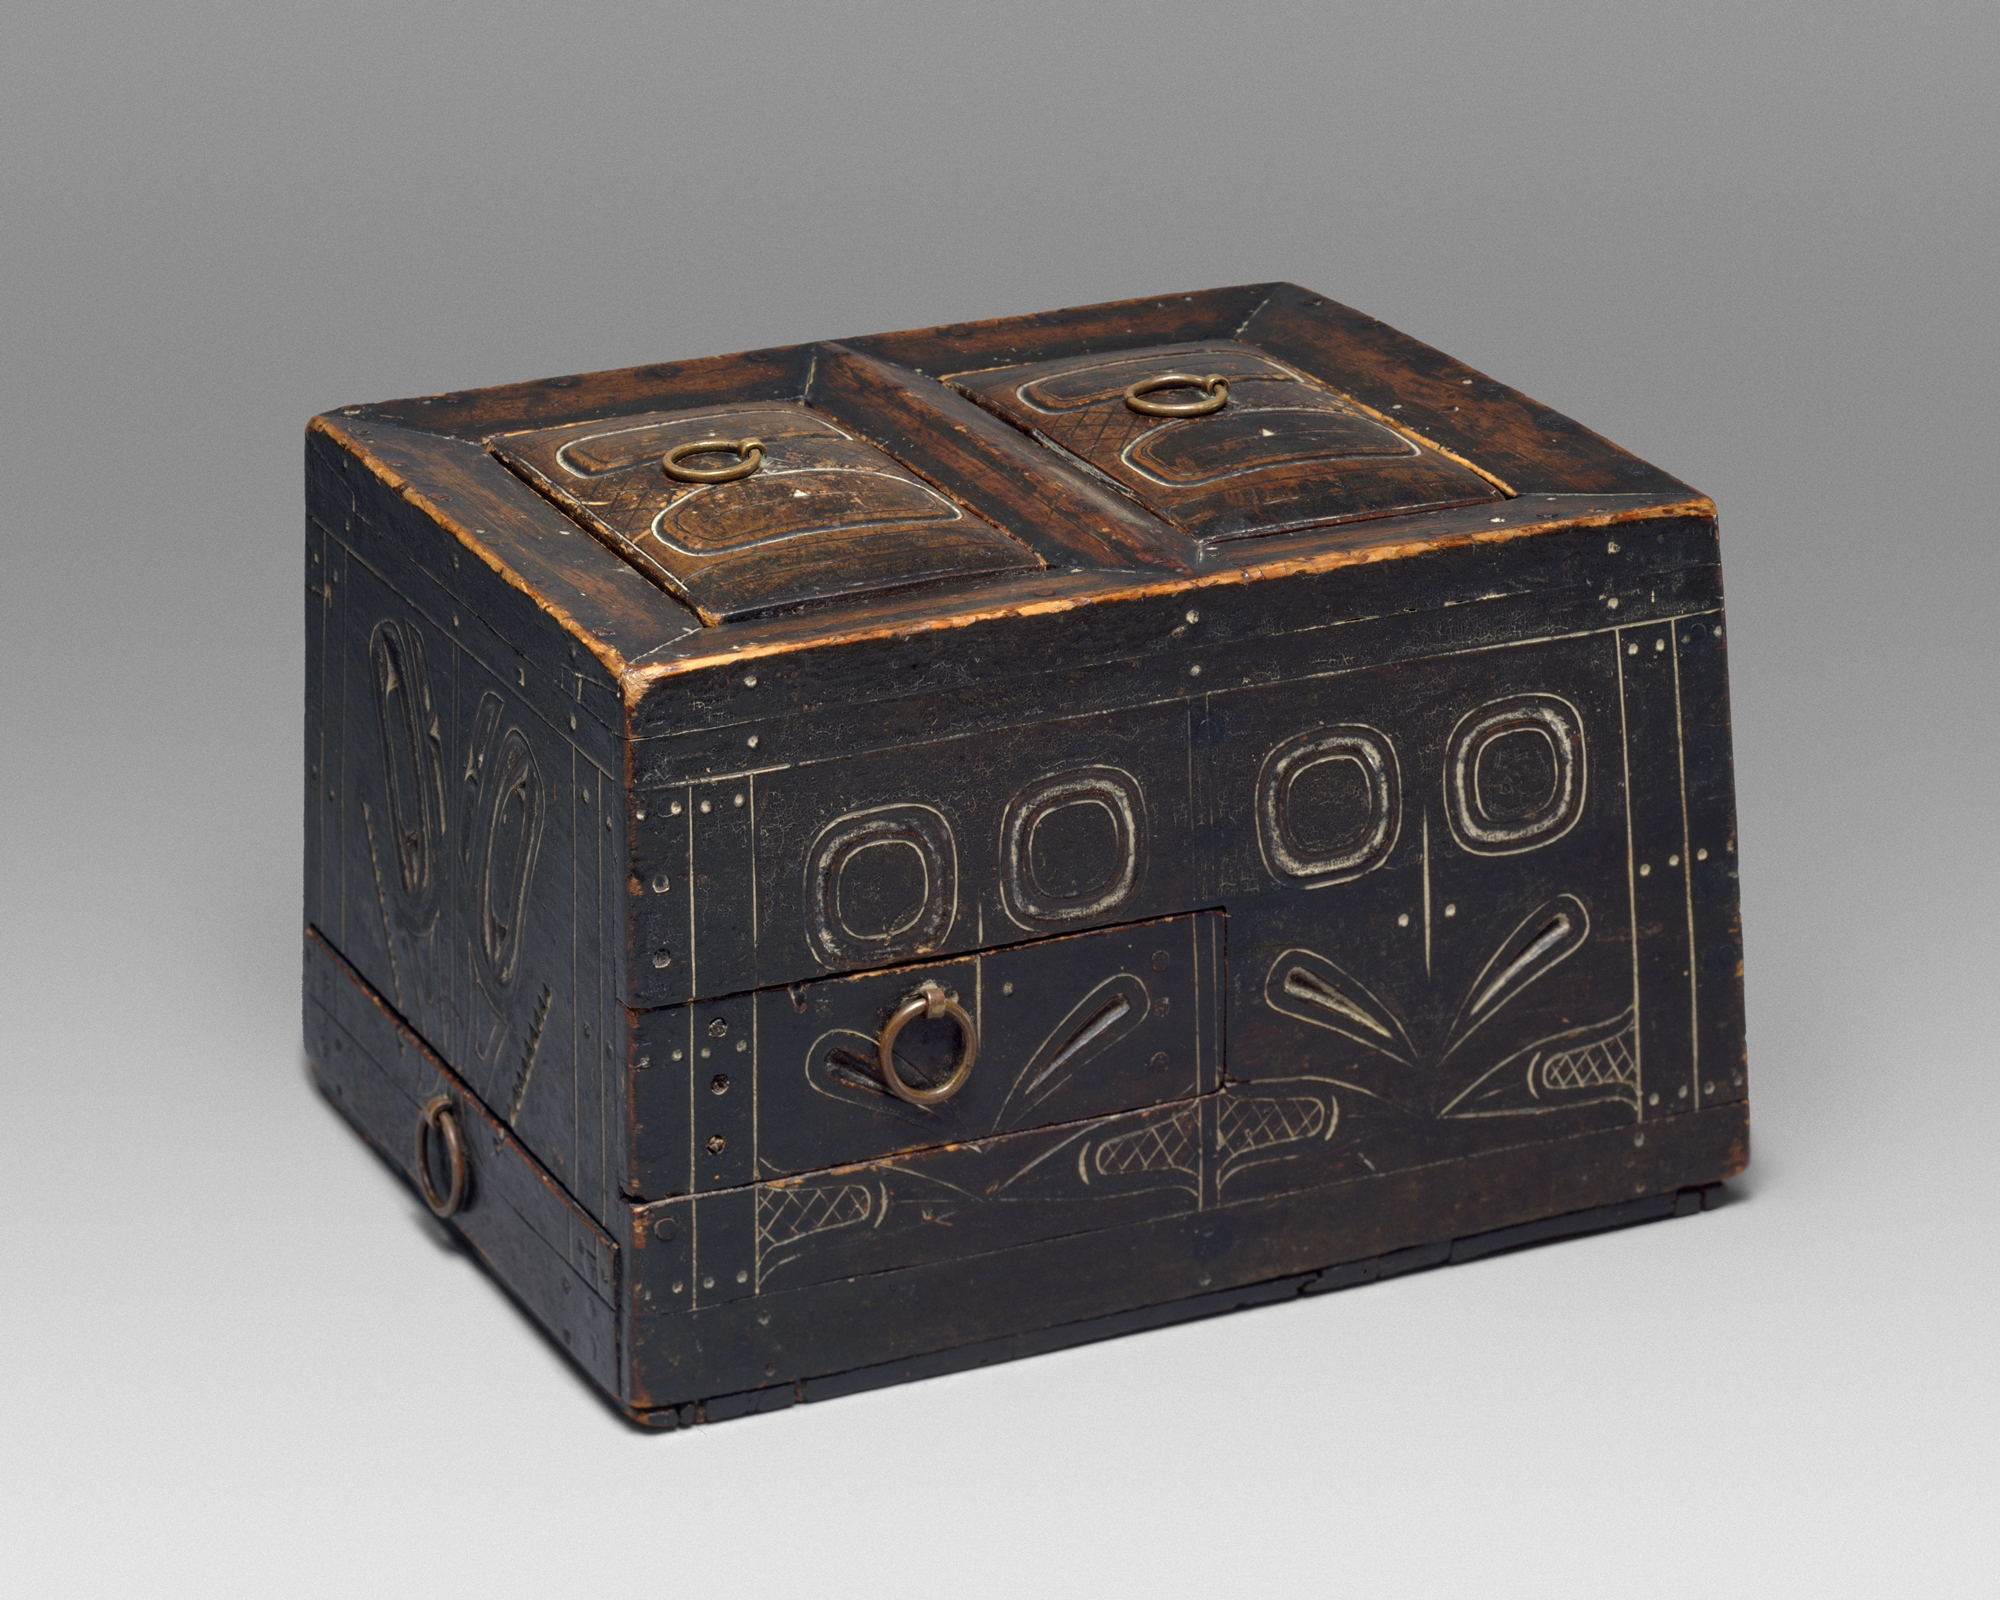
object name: box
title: Utility Box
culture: yup'ik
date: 1825-1830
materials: metal, wood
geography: united states